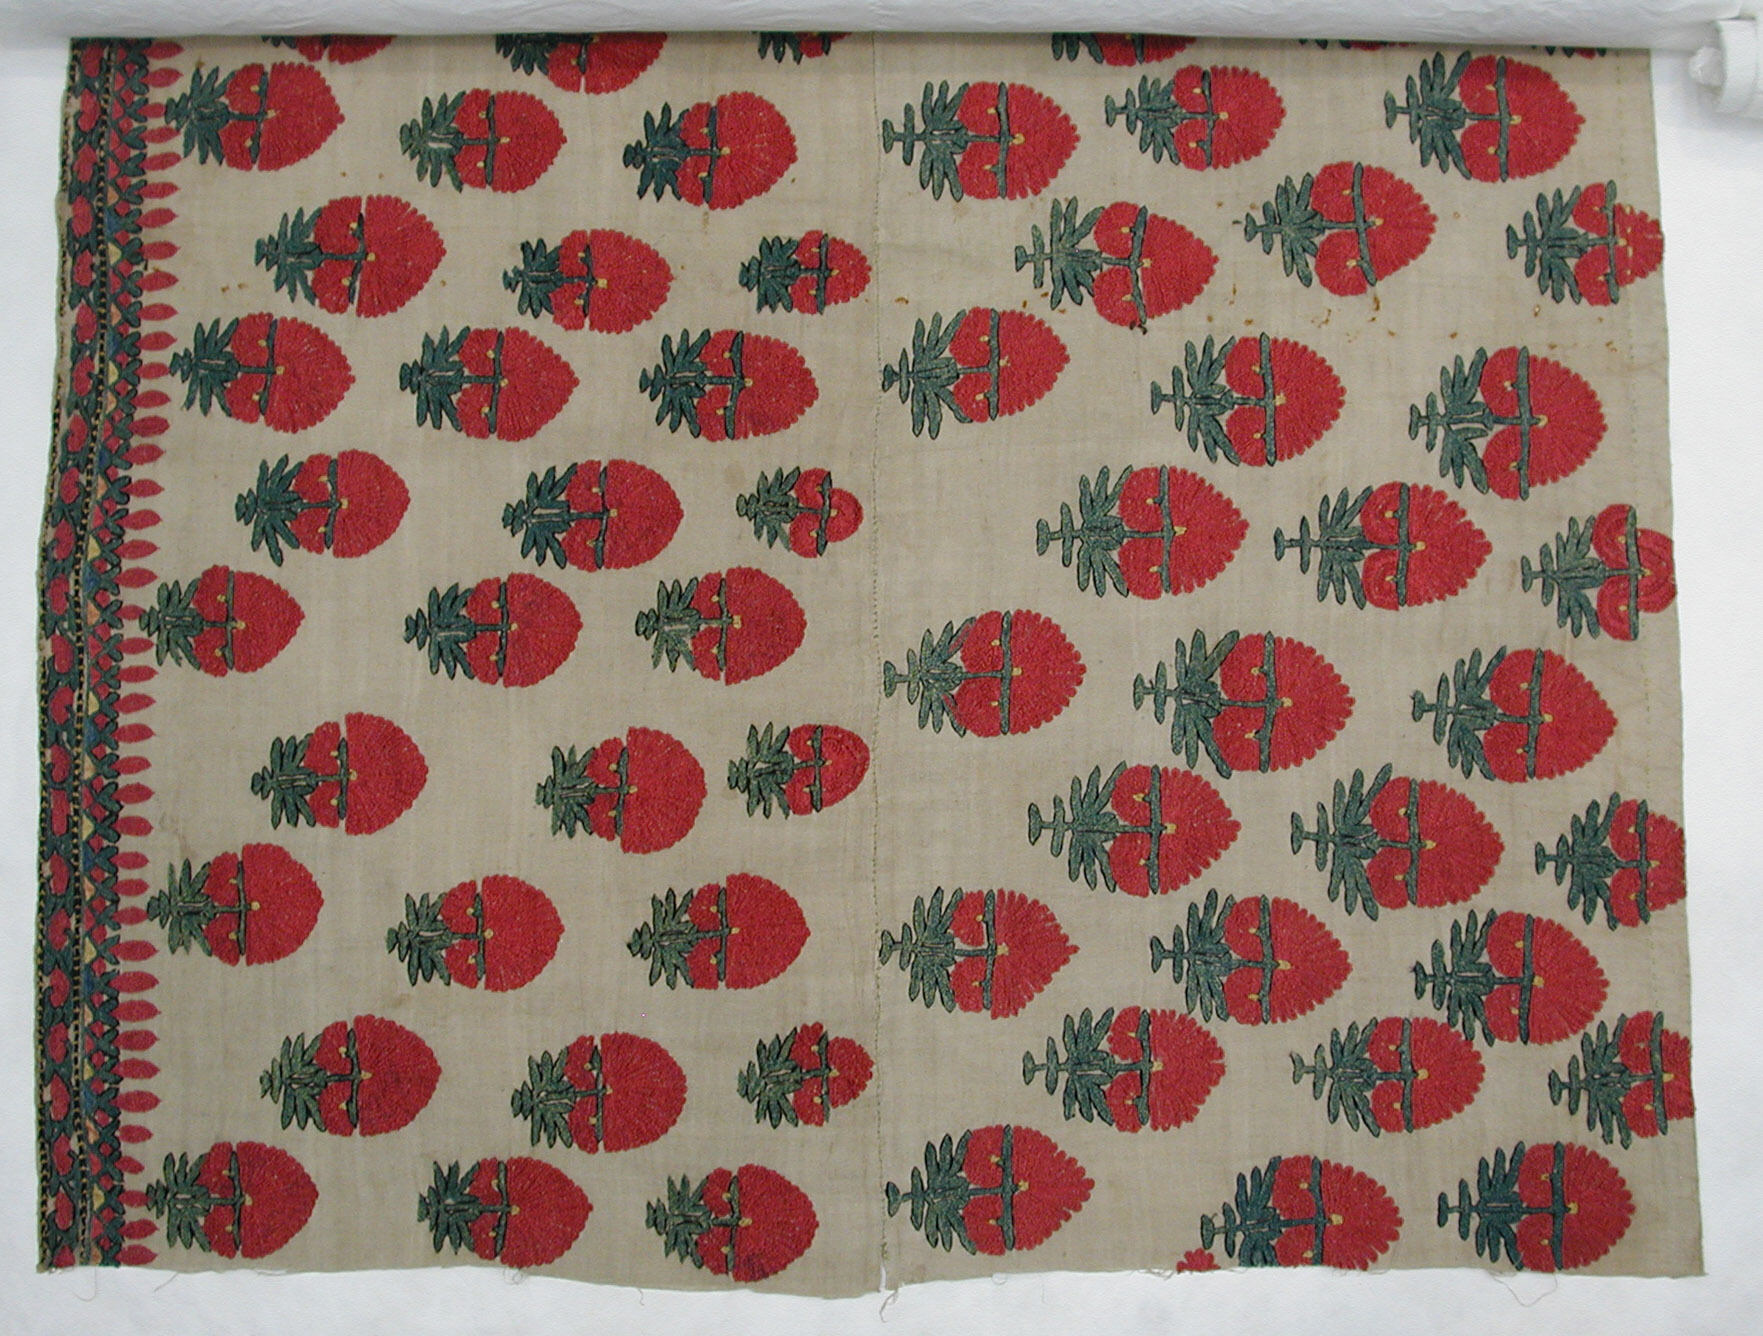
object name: hanging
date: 1701-1800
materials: linen, silk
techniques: embroidery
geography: india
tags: flowers